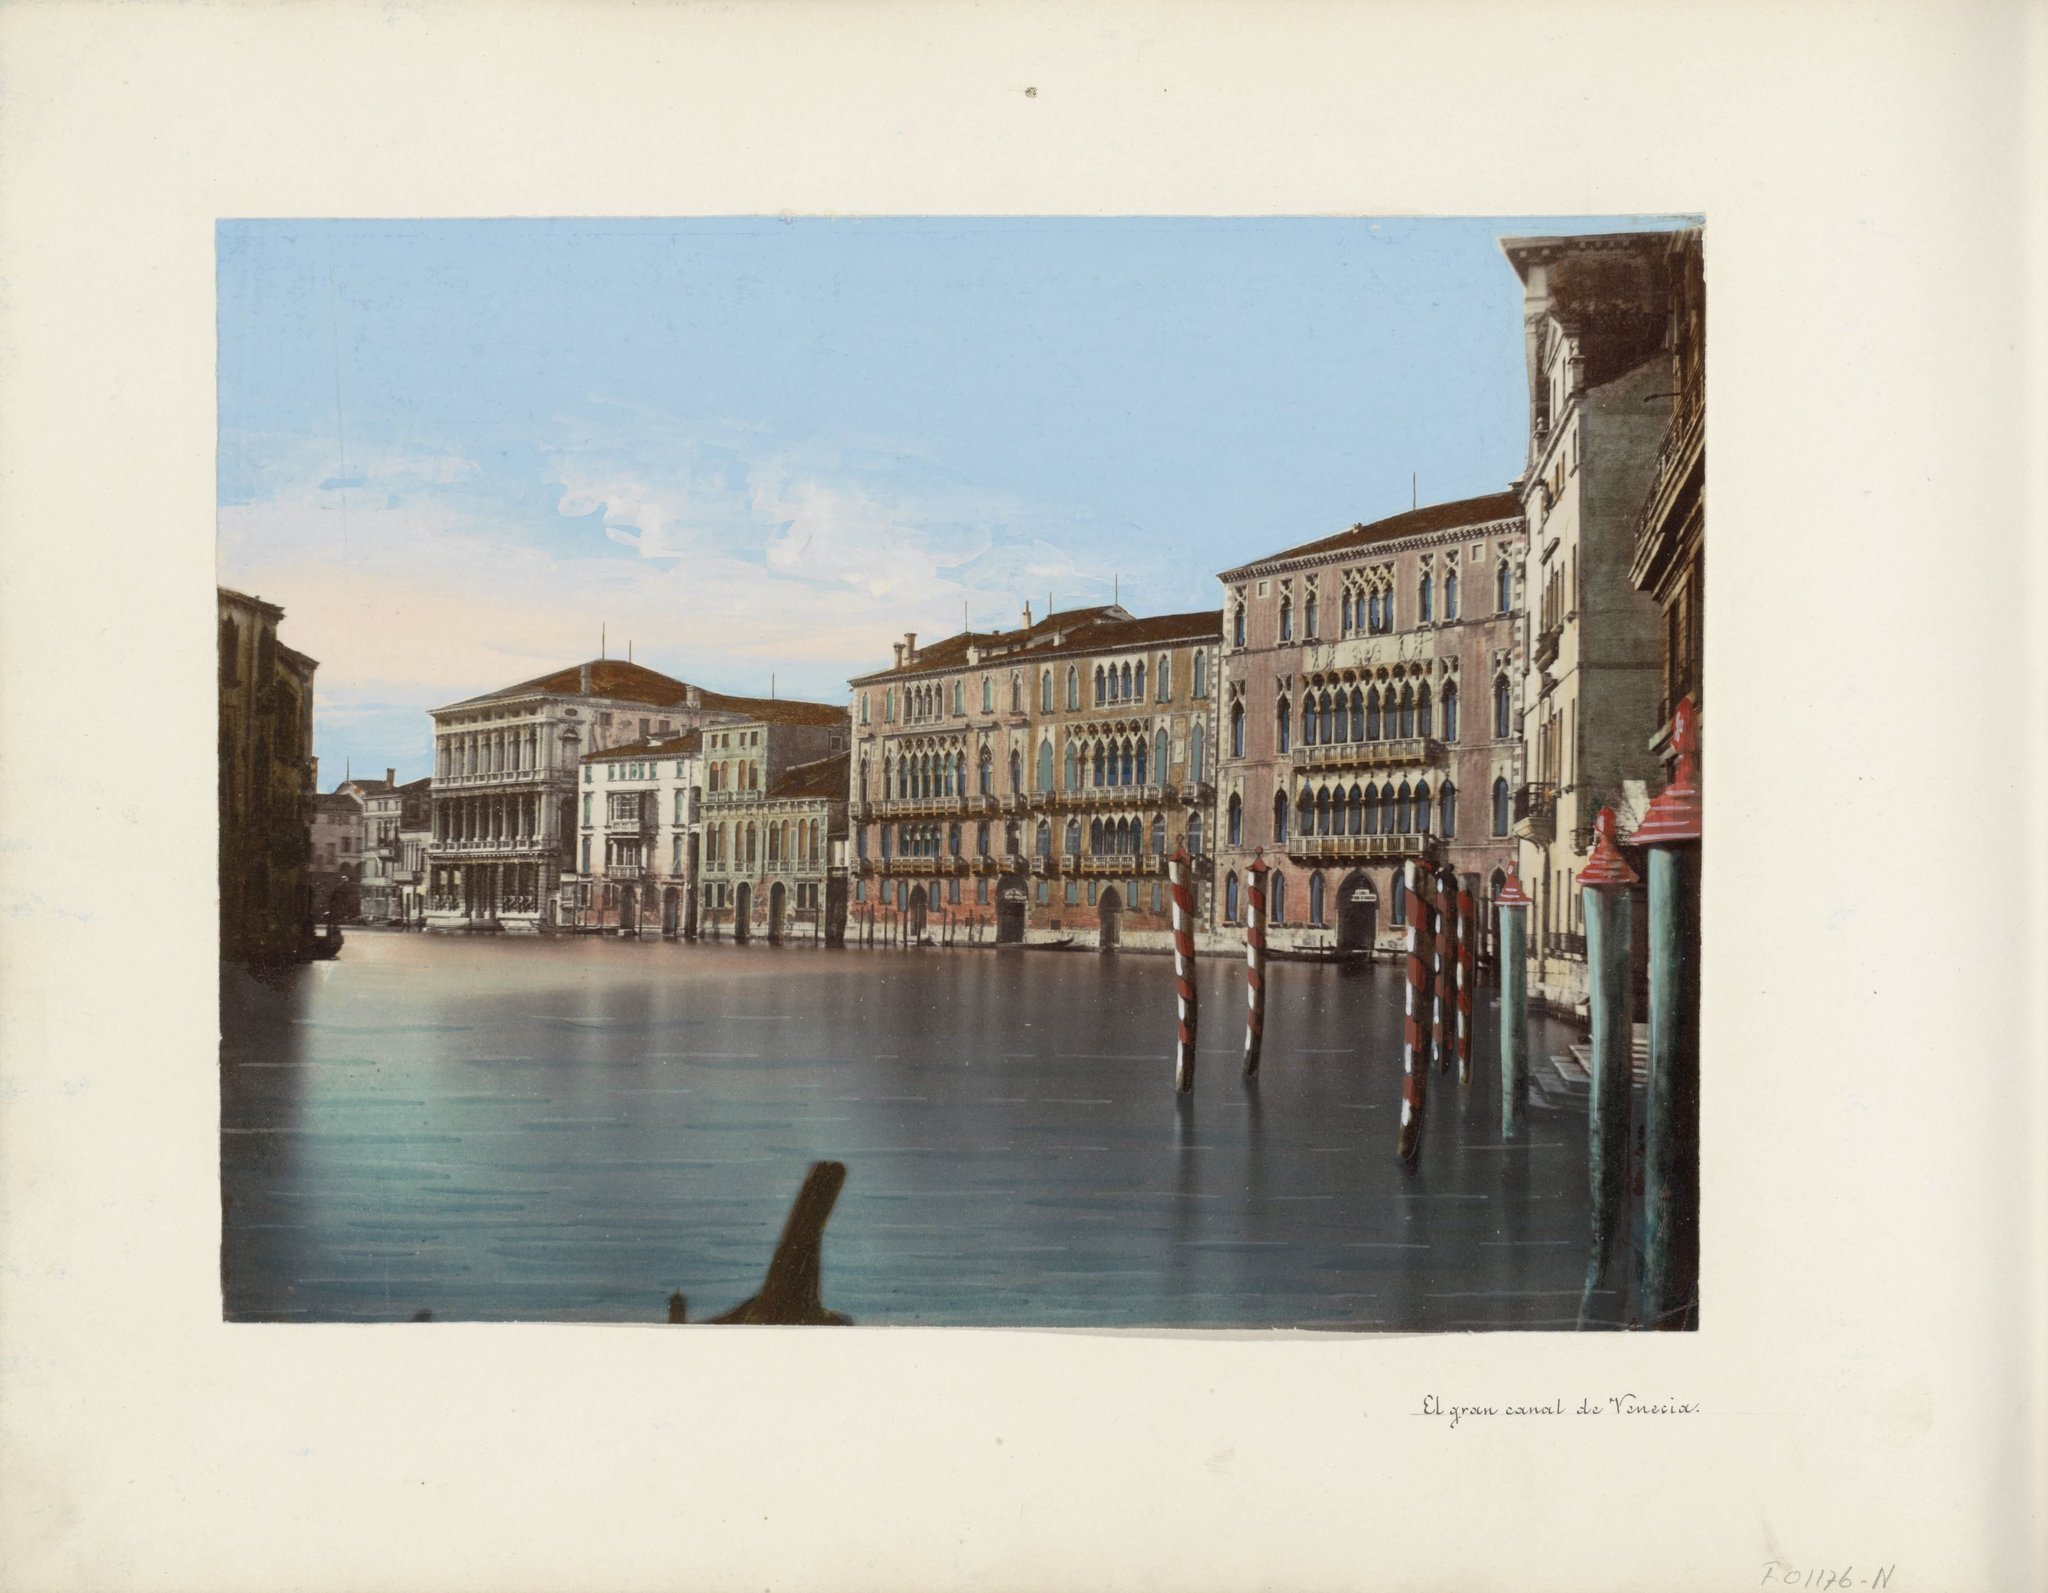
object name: photograph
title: Bocht in het Canal Grande in Venetië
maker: Anonymous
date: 1850-1876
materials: paint, photographic support, watercolor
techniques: albumen print, hand coloring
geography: venice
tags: canal, palace, travelling; tourism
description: Onderdeel van Reisalbum met foto's en tekeningen van Manuel Mayo 1876.